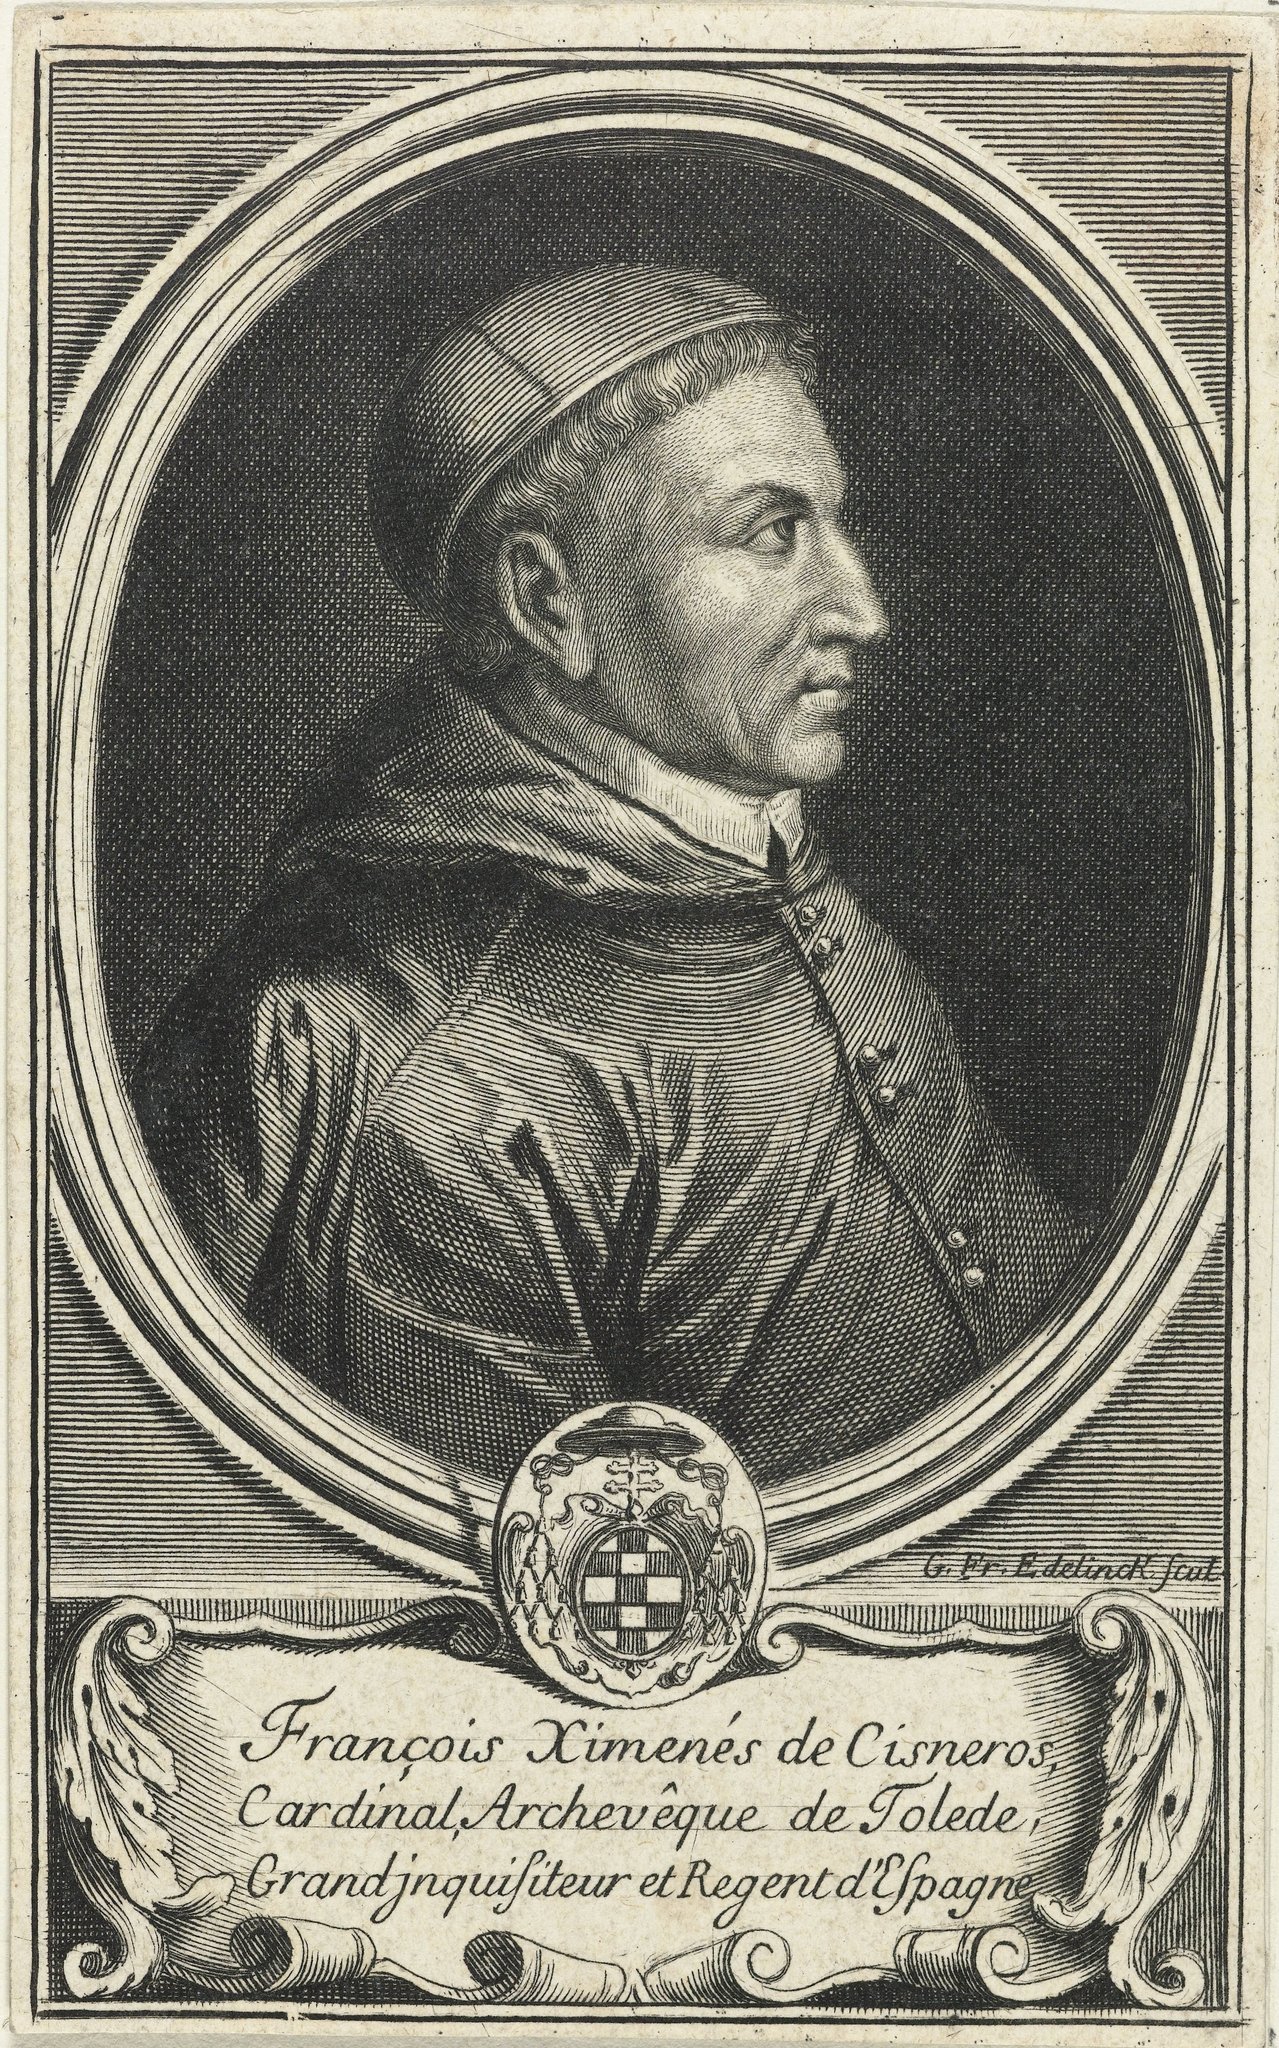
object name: print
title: Portret van Francisco Jiménez de Cisneros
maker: gaspar françois edelinck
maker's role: print maker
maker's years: 1652-1722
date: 1654-1722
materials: paper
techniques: engraving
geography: paris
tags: madrid, francisco jiménez de cisneros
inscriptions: collector's mark: Lugt 2228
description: Portret van de Spaanse kardinaal en staatsman Francisco Jiménez de Cisneros (1436-1517), afgebeeld in ovale omlijsting met wapen. Onder het wapen een cartouche met drie regels Franse tekst.